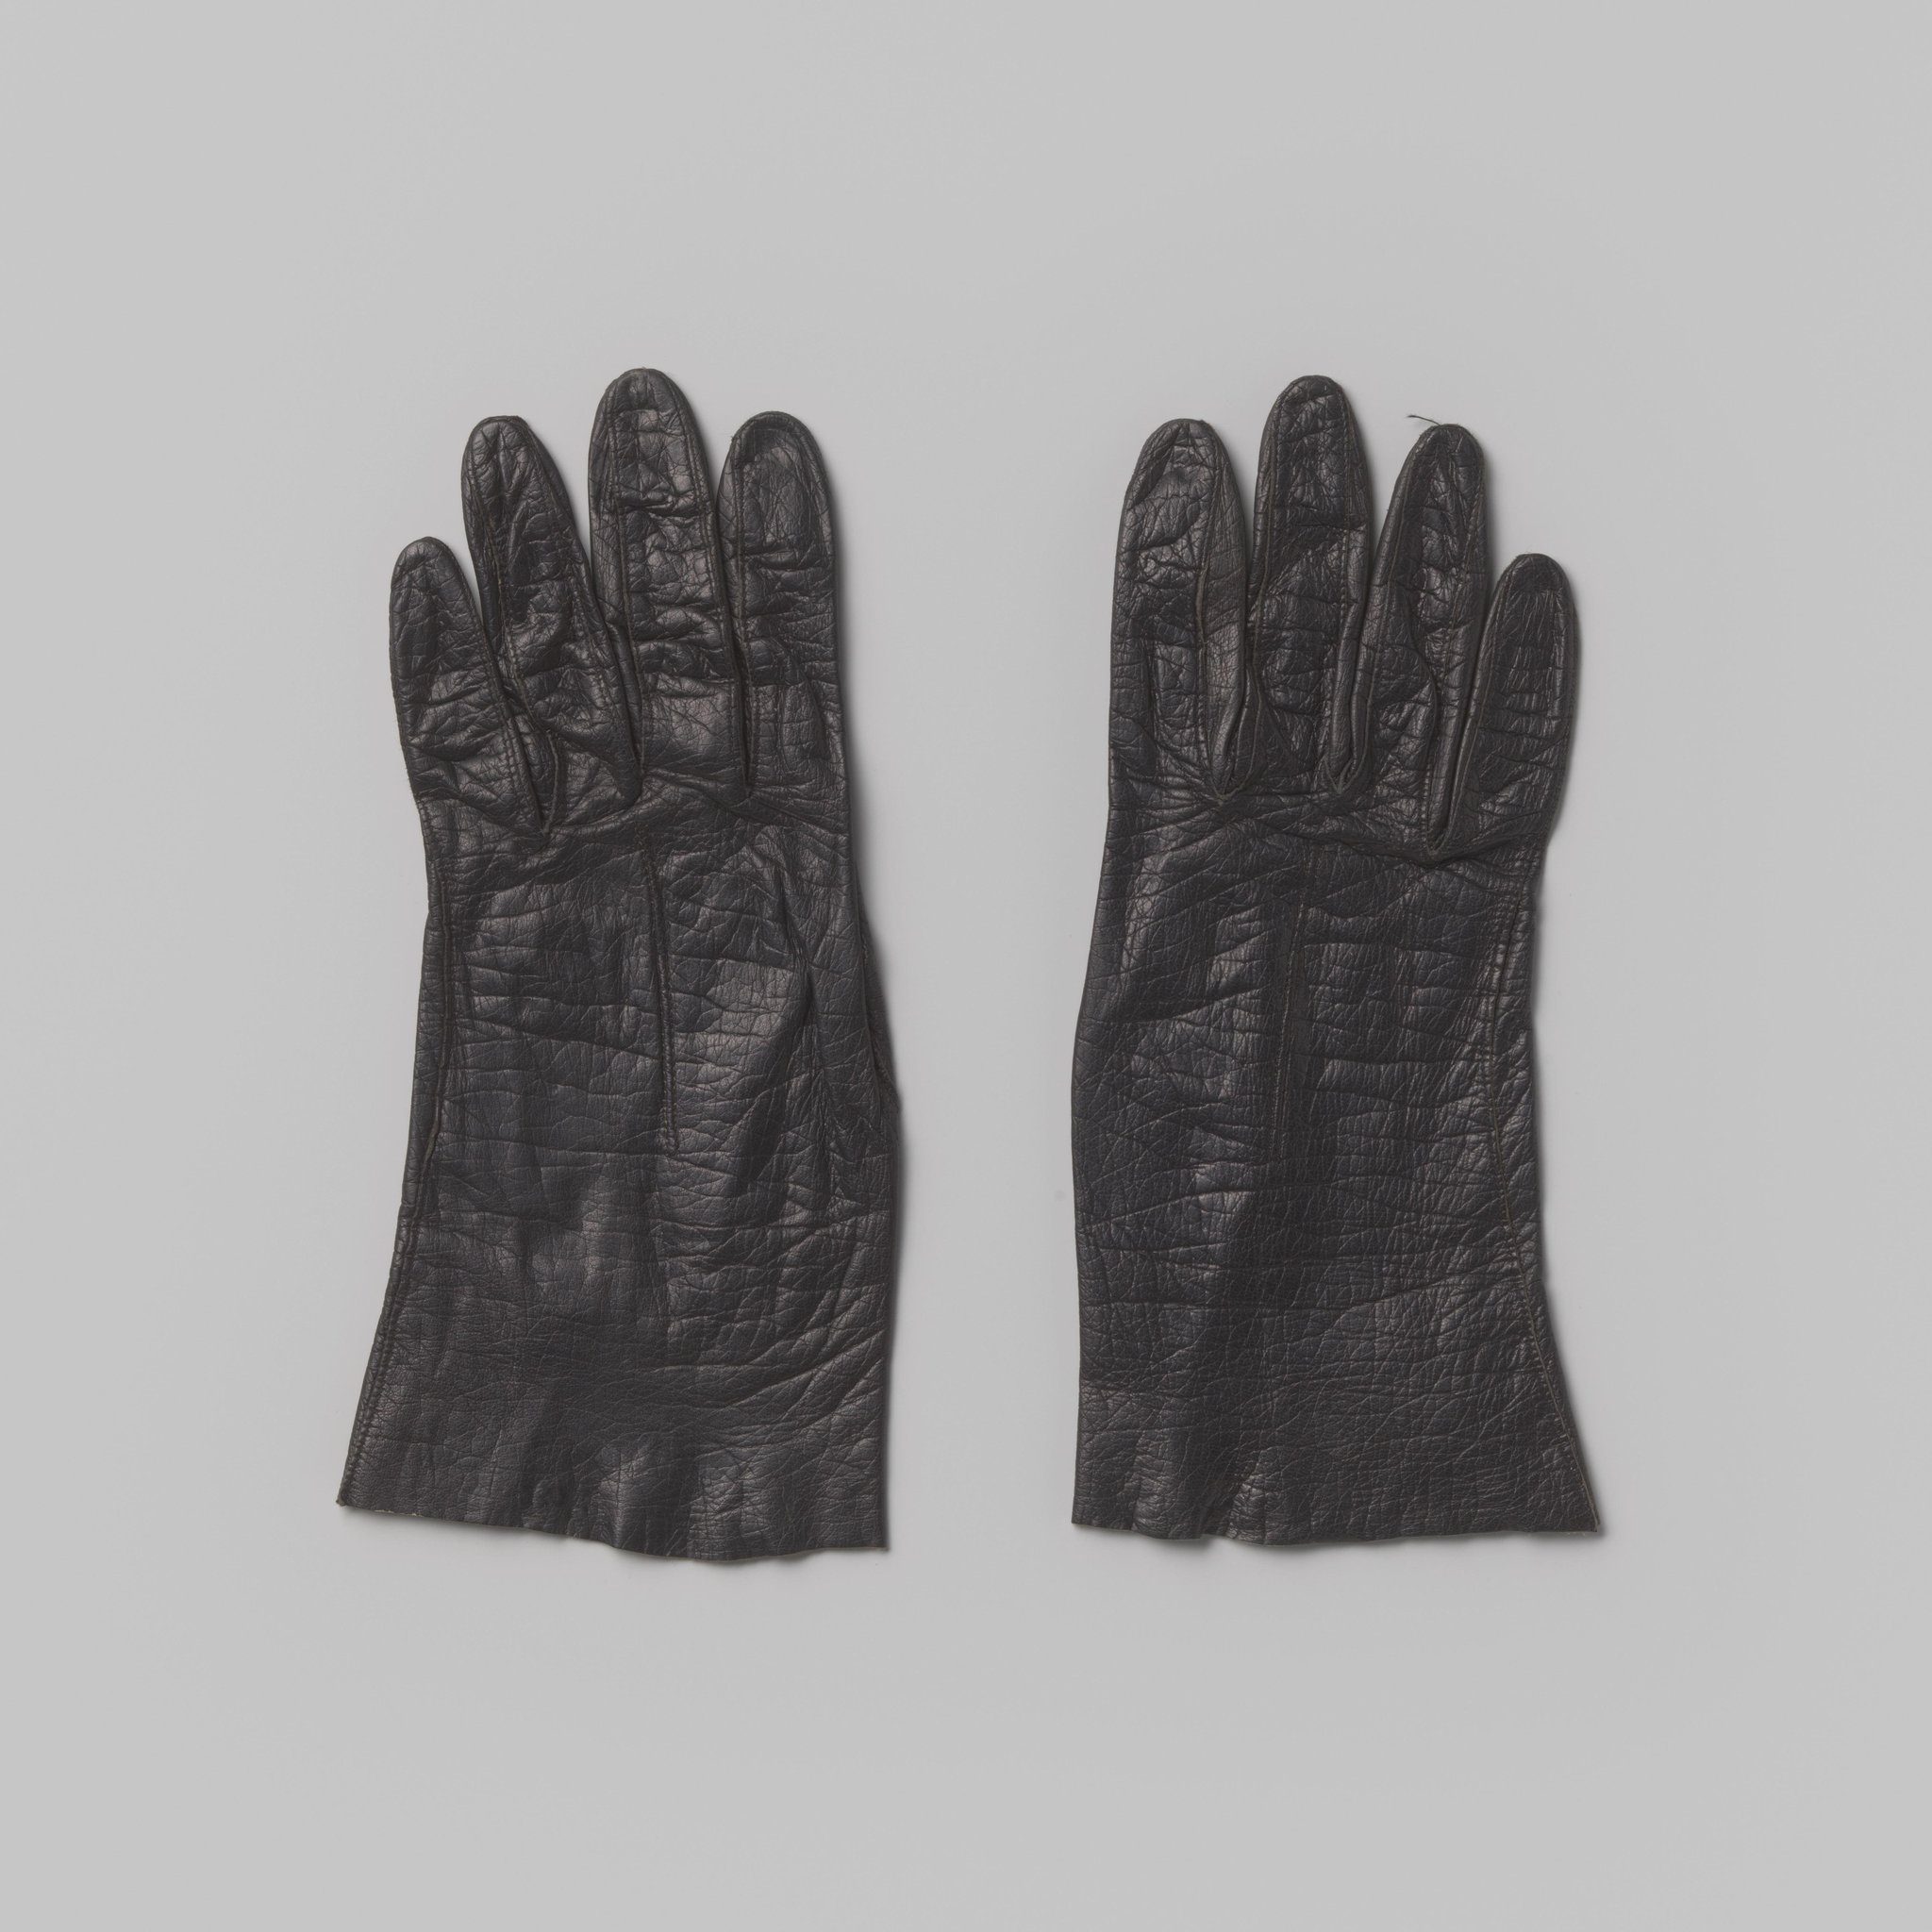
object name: glove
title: Dameshandschoen van zwart glacéleer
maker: Anonymous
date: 1950-1960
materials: glazing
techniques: glazing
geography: amsterdam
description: Rechterdameshandschoen van zwart glacéleer. Model: kort, met één peesnaadje op de handrug.